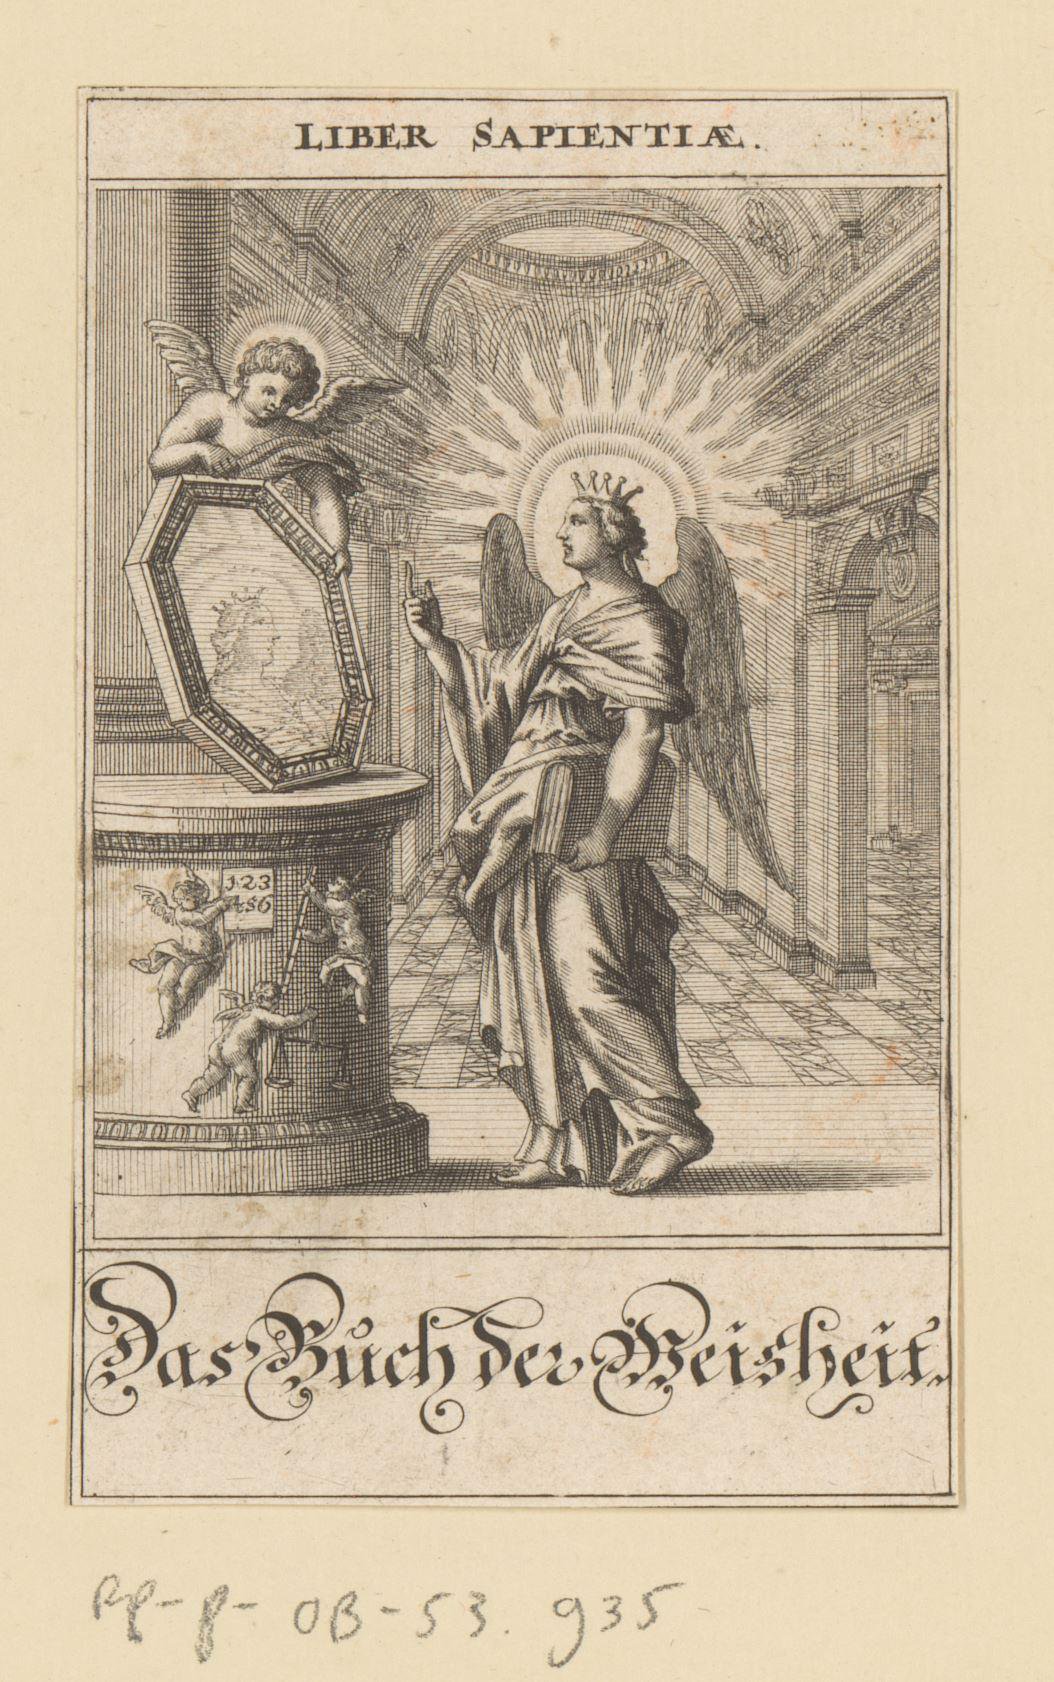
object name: print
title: Wijsheid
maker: Anonymous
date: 1697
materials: paper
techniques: etching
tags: wisdom; 'sapienza', 'sapienza humana', 'sapienza vera' (ripa), the books of wisdom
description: Prent ook gebruikt in: Biblia ectypa : Bildnussen auss Heiliger Schrifft. Regensburg: Chr. Wiegel, 1697.